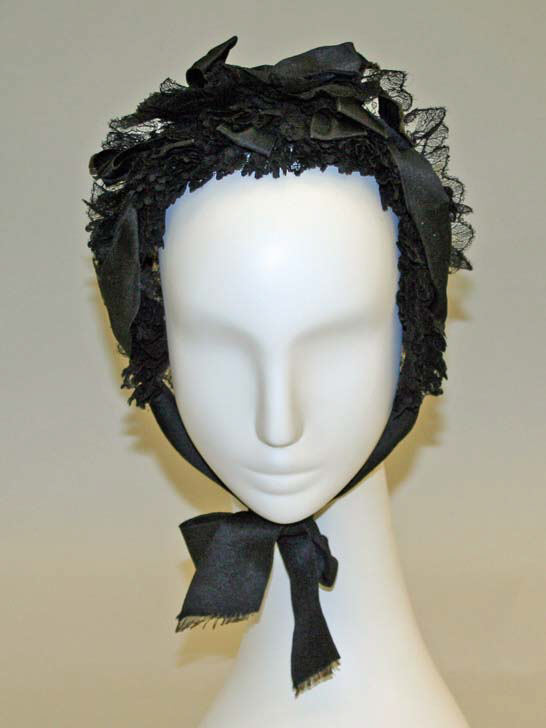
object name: bonnet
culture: american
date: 1834-1866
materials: silk